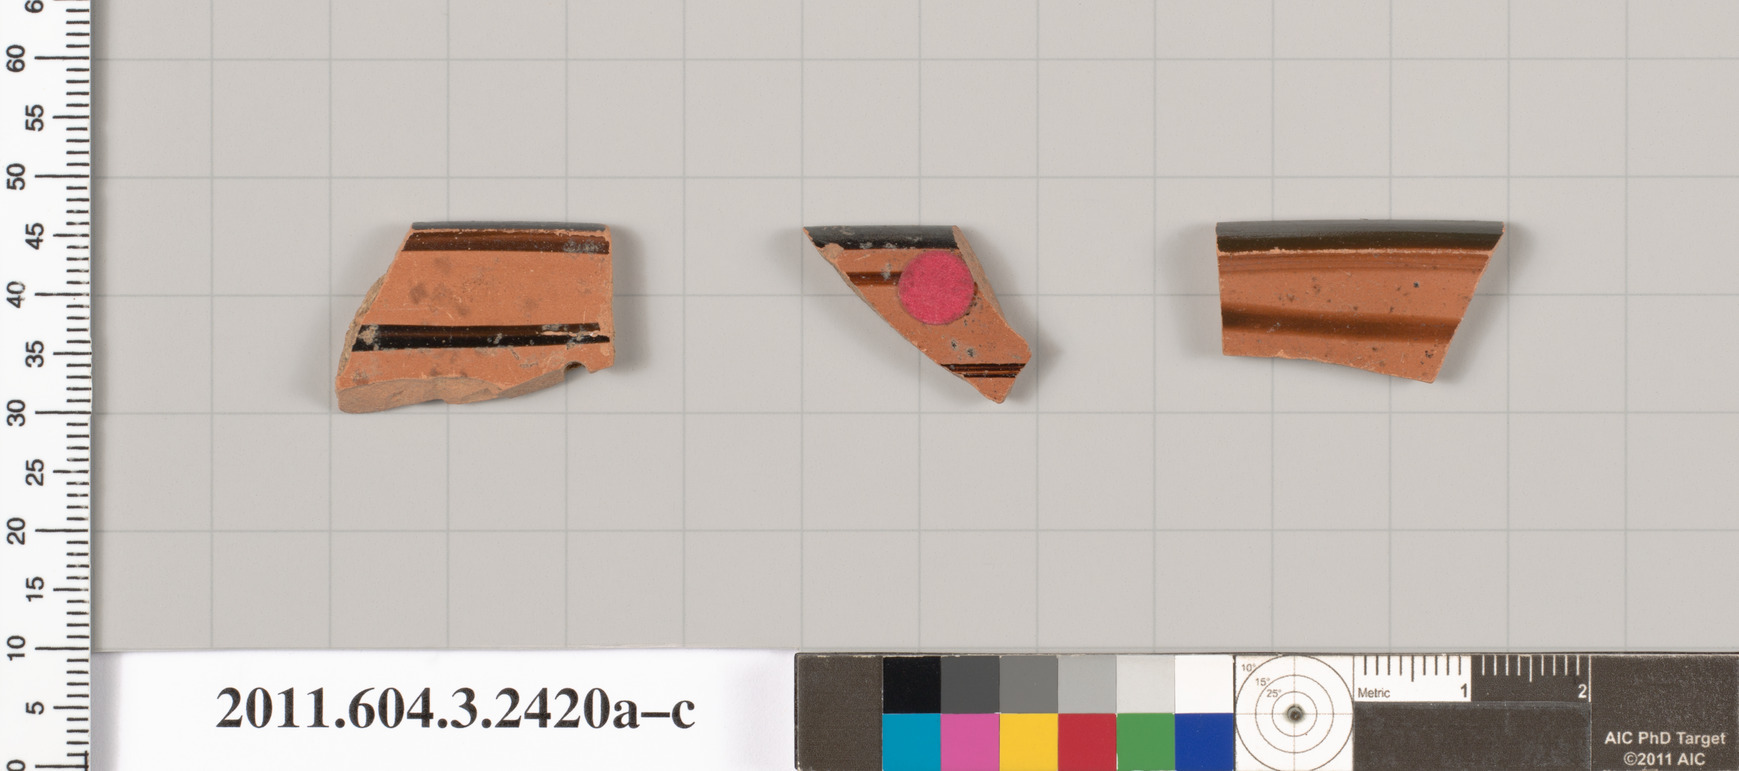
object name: kylix fragment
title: Terracotta rim fragments of kylikes: eye-cups (drinking cups)?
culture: greek, attic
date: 540-510 BCE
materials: terracotta